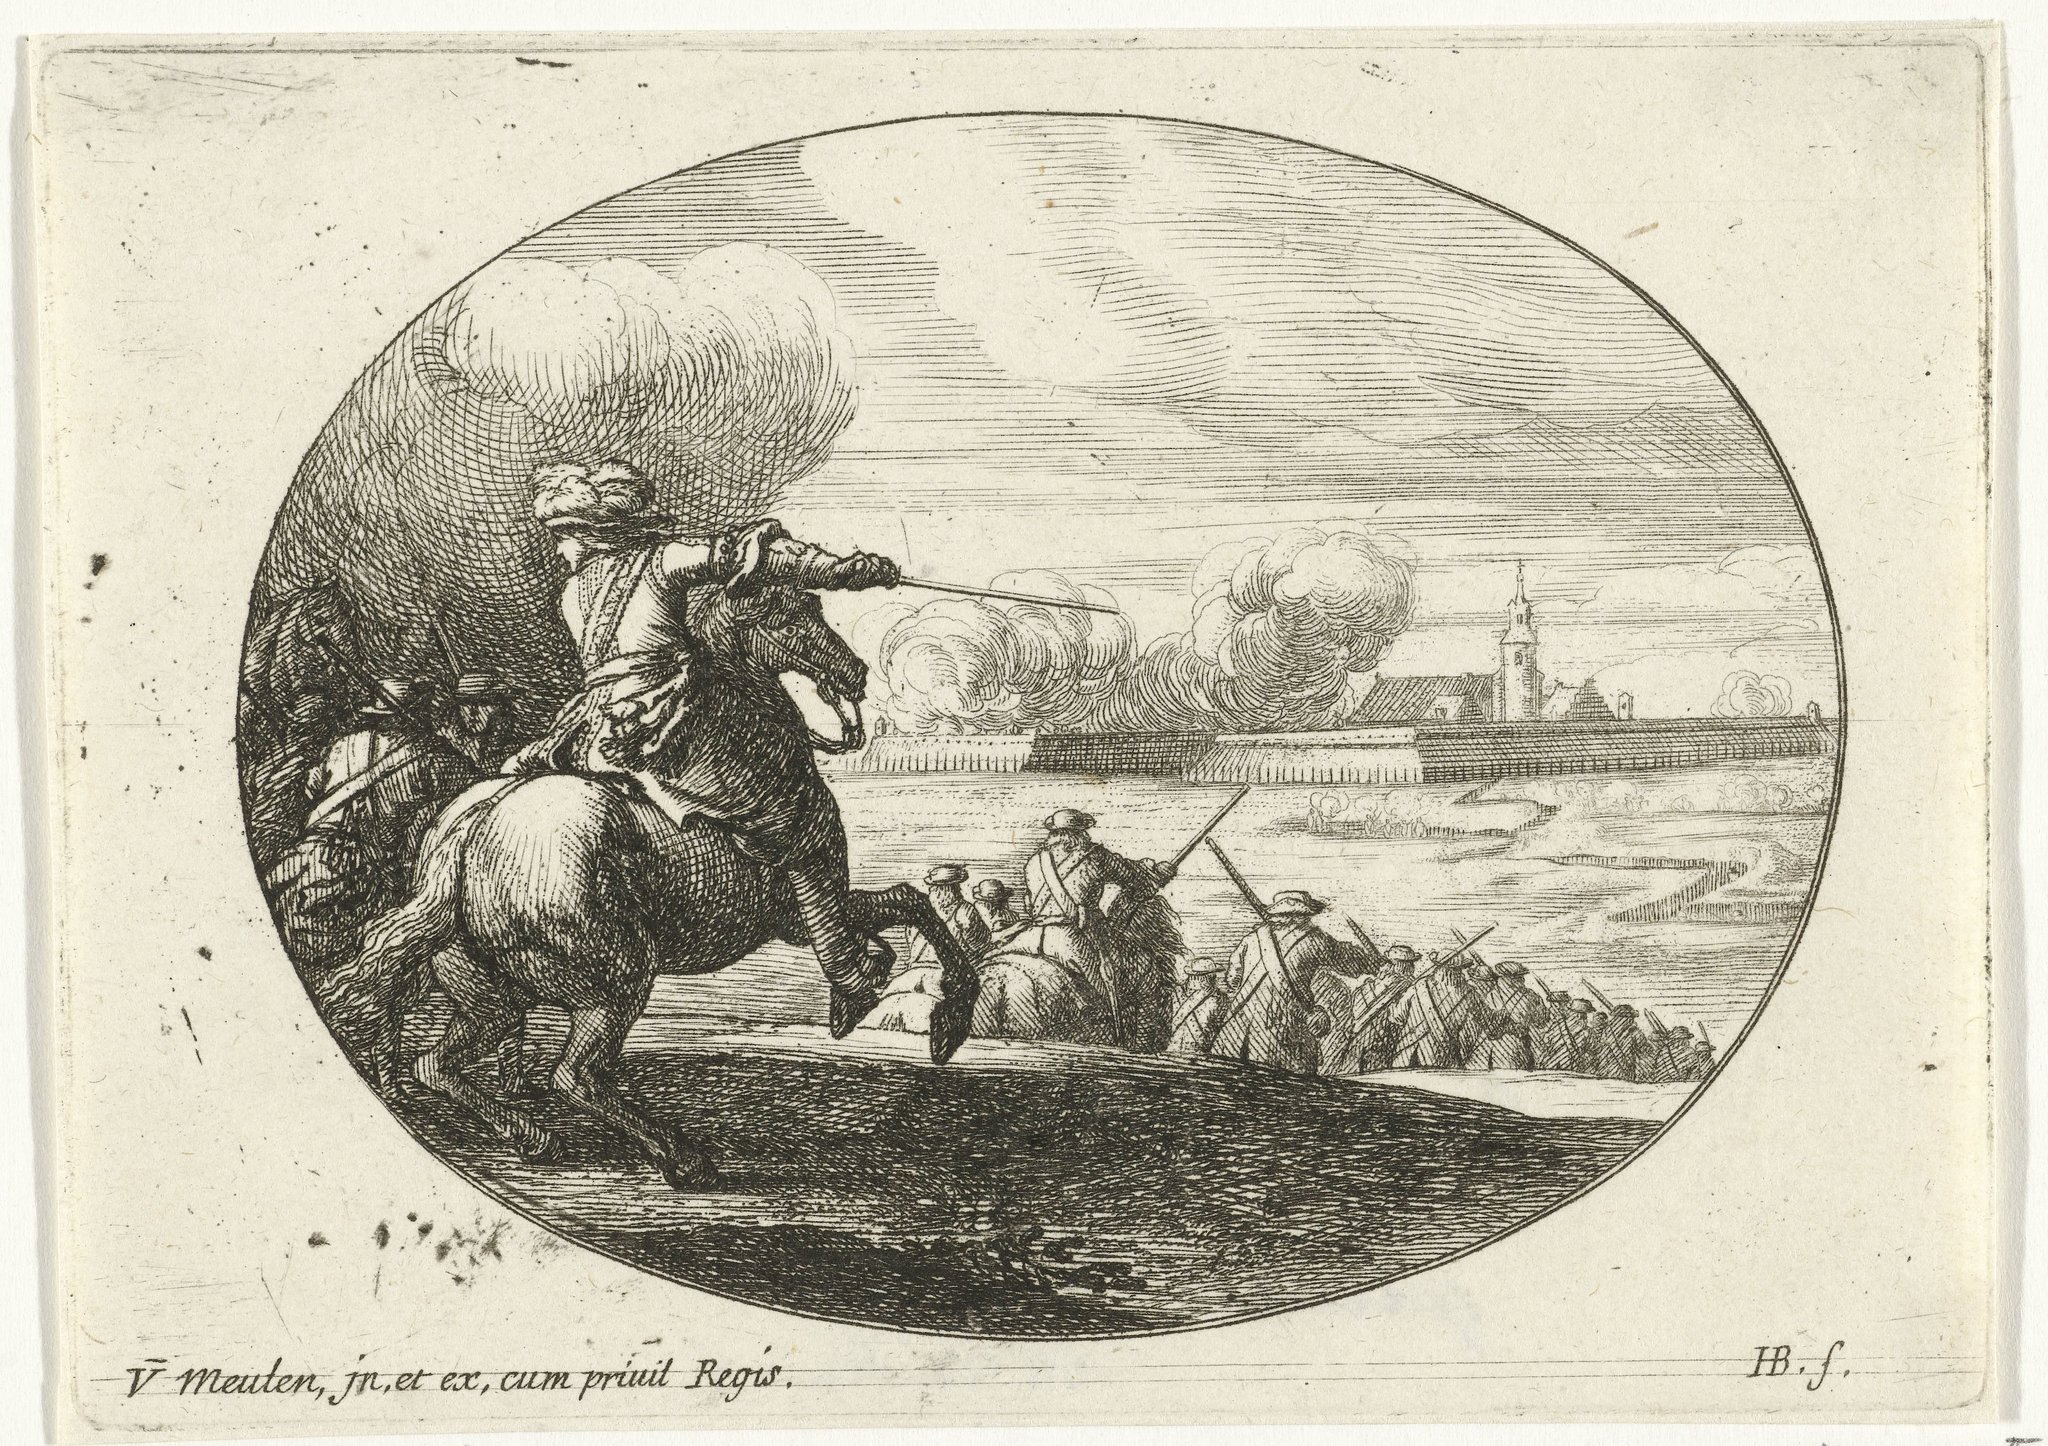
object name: print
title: Belegering van een stad met stadswallen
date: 1674-1733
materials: paper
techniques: etching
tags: lodewijk xiv (koning van frankrijk), historical persons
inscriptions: collector's mark: Lugt 2228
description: Links ruiters en paarden, één ruiter wijst naar de stad aan de horizon. Rechts een stoet soldaten op de rug gezien.